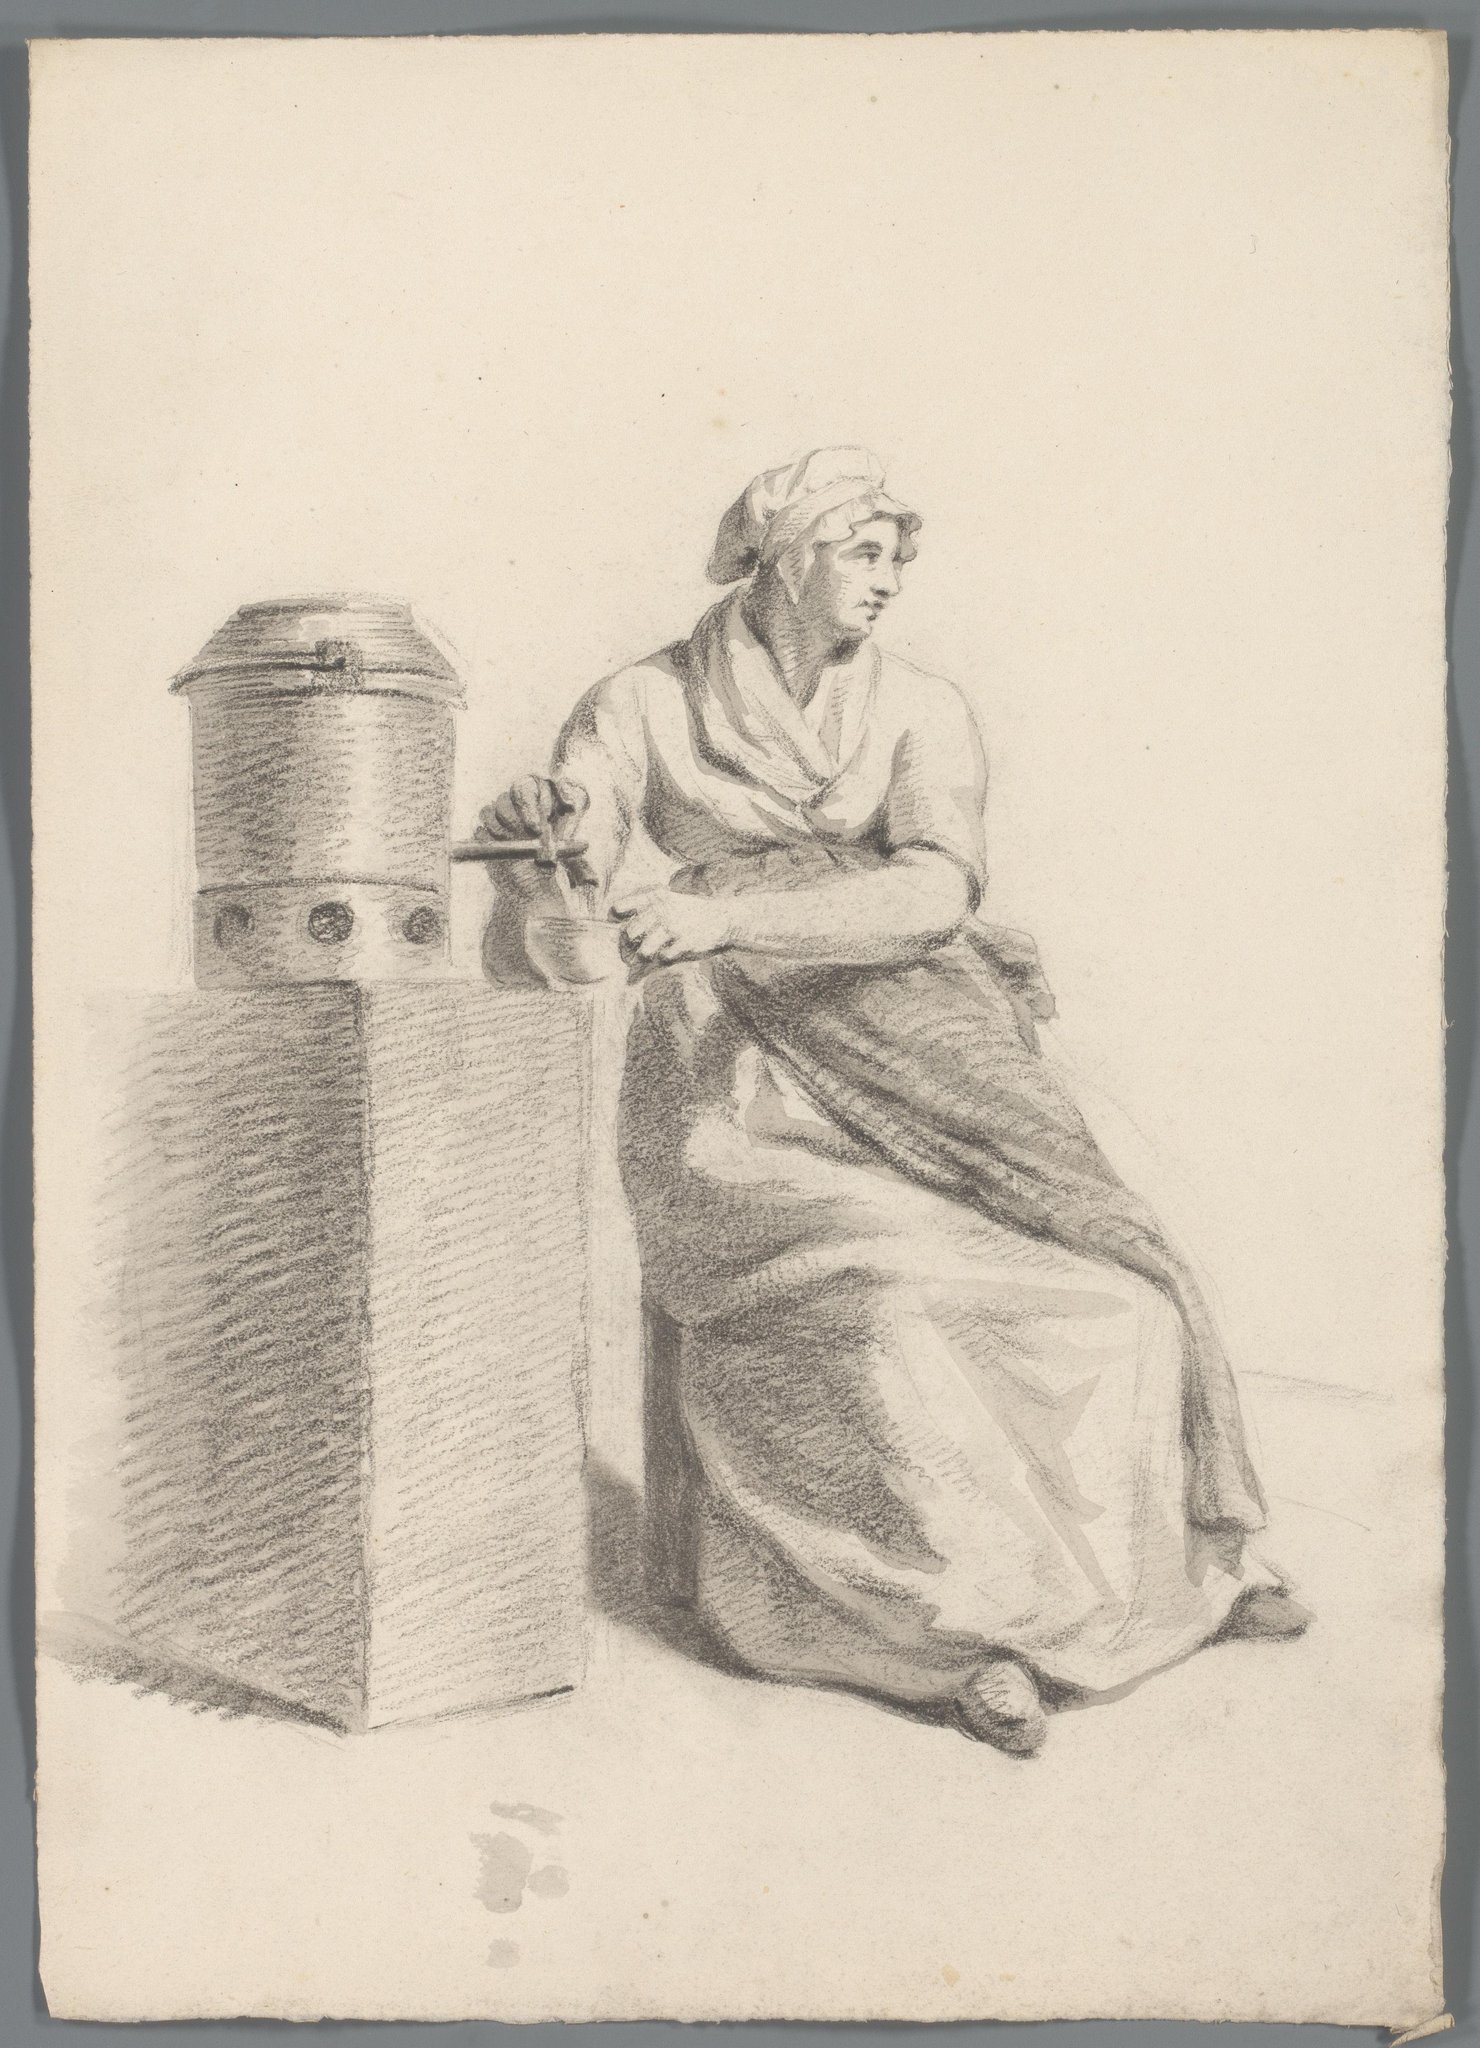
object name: drawing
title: Zittende vrouw die een kopje onder een soort kraan houdt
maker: Anonymous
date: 1820-1830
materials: chalk, paper, watercolor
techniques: brush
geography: the hague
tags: adult woman, sitting figure - aa - female human figure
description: Tekeningen waarschijnlijk ontstaan bij het Haagse kunstgenootschap ‘Tot Nut der Tekenkunst’, waar twee keer per week tekenavonden werden georganiseerd met geklede modellen.